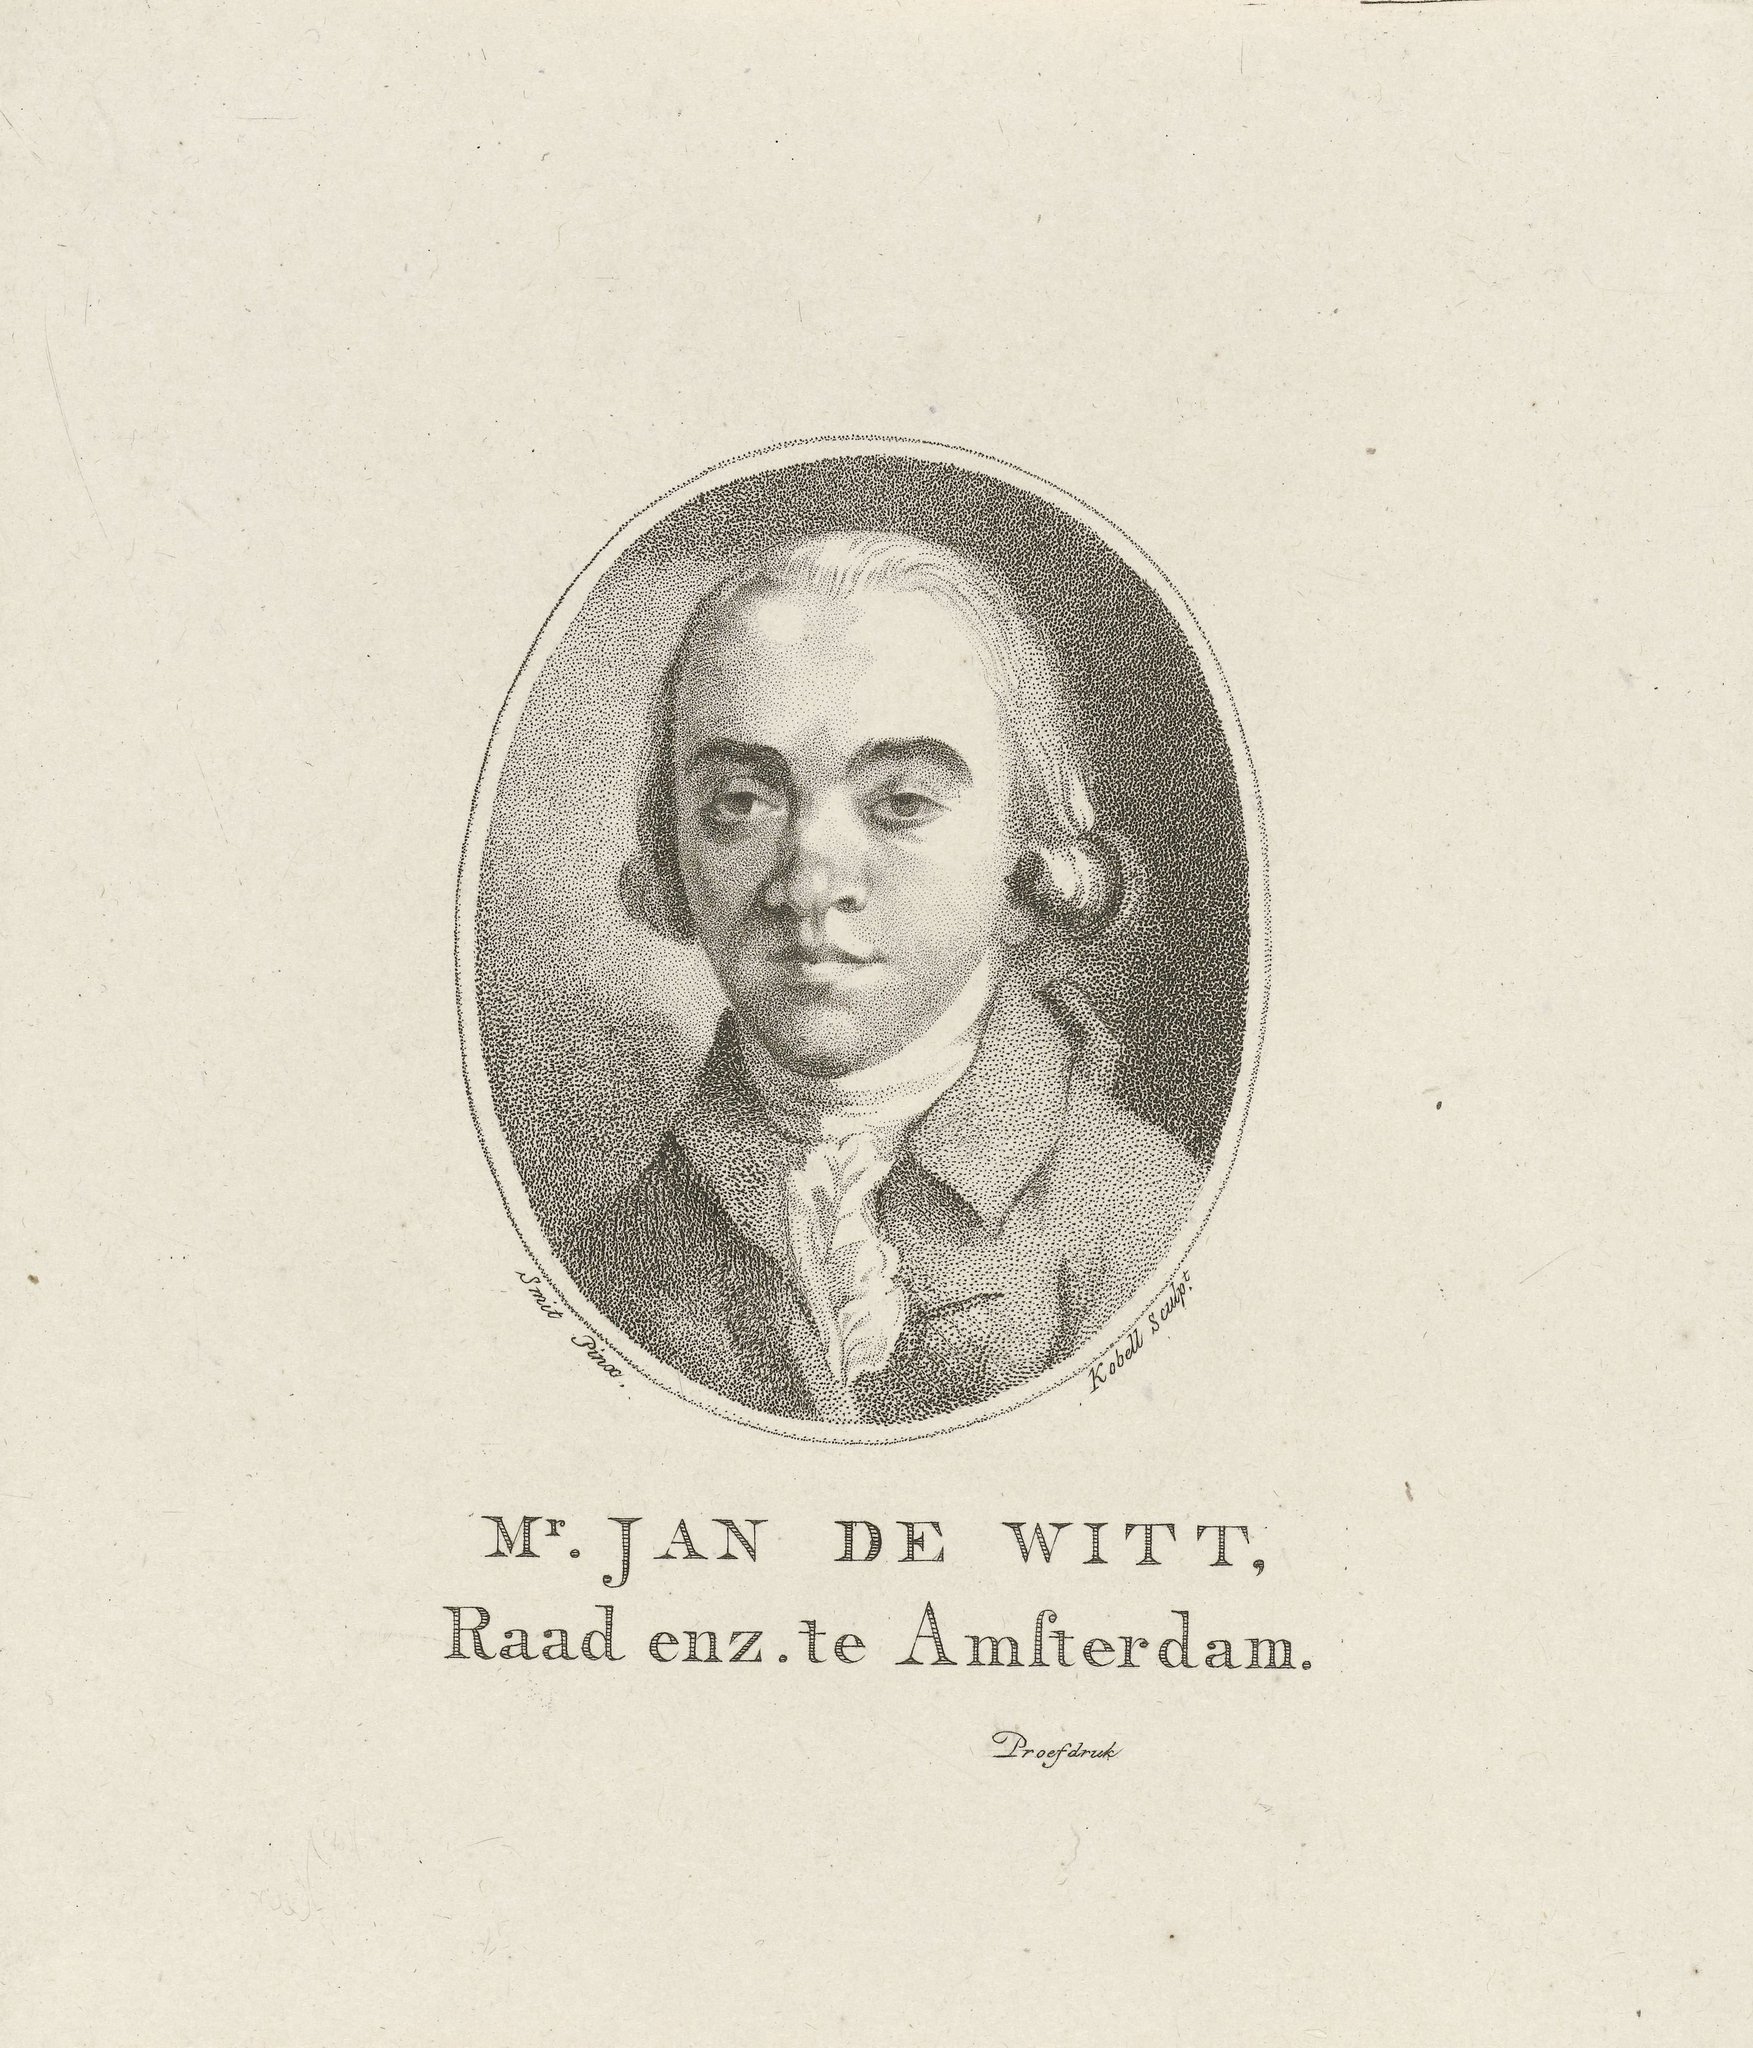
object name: print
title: Mr. Jan de Witt, Raad enz. te Amsterdam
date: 1766-1833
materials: paper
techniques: etching, engraving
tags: amsterdam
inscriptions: collector's mark: Lugt 2228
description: Portretbuste in ovaal van Jan de Witt, van voren gezien.